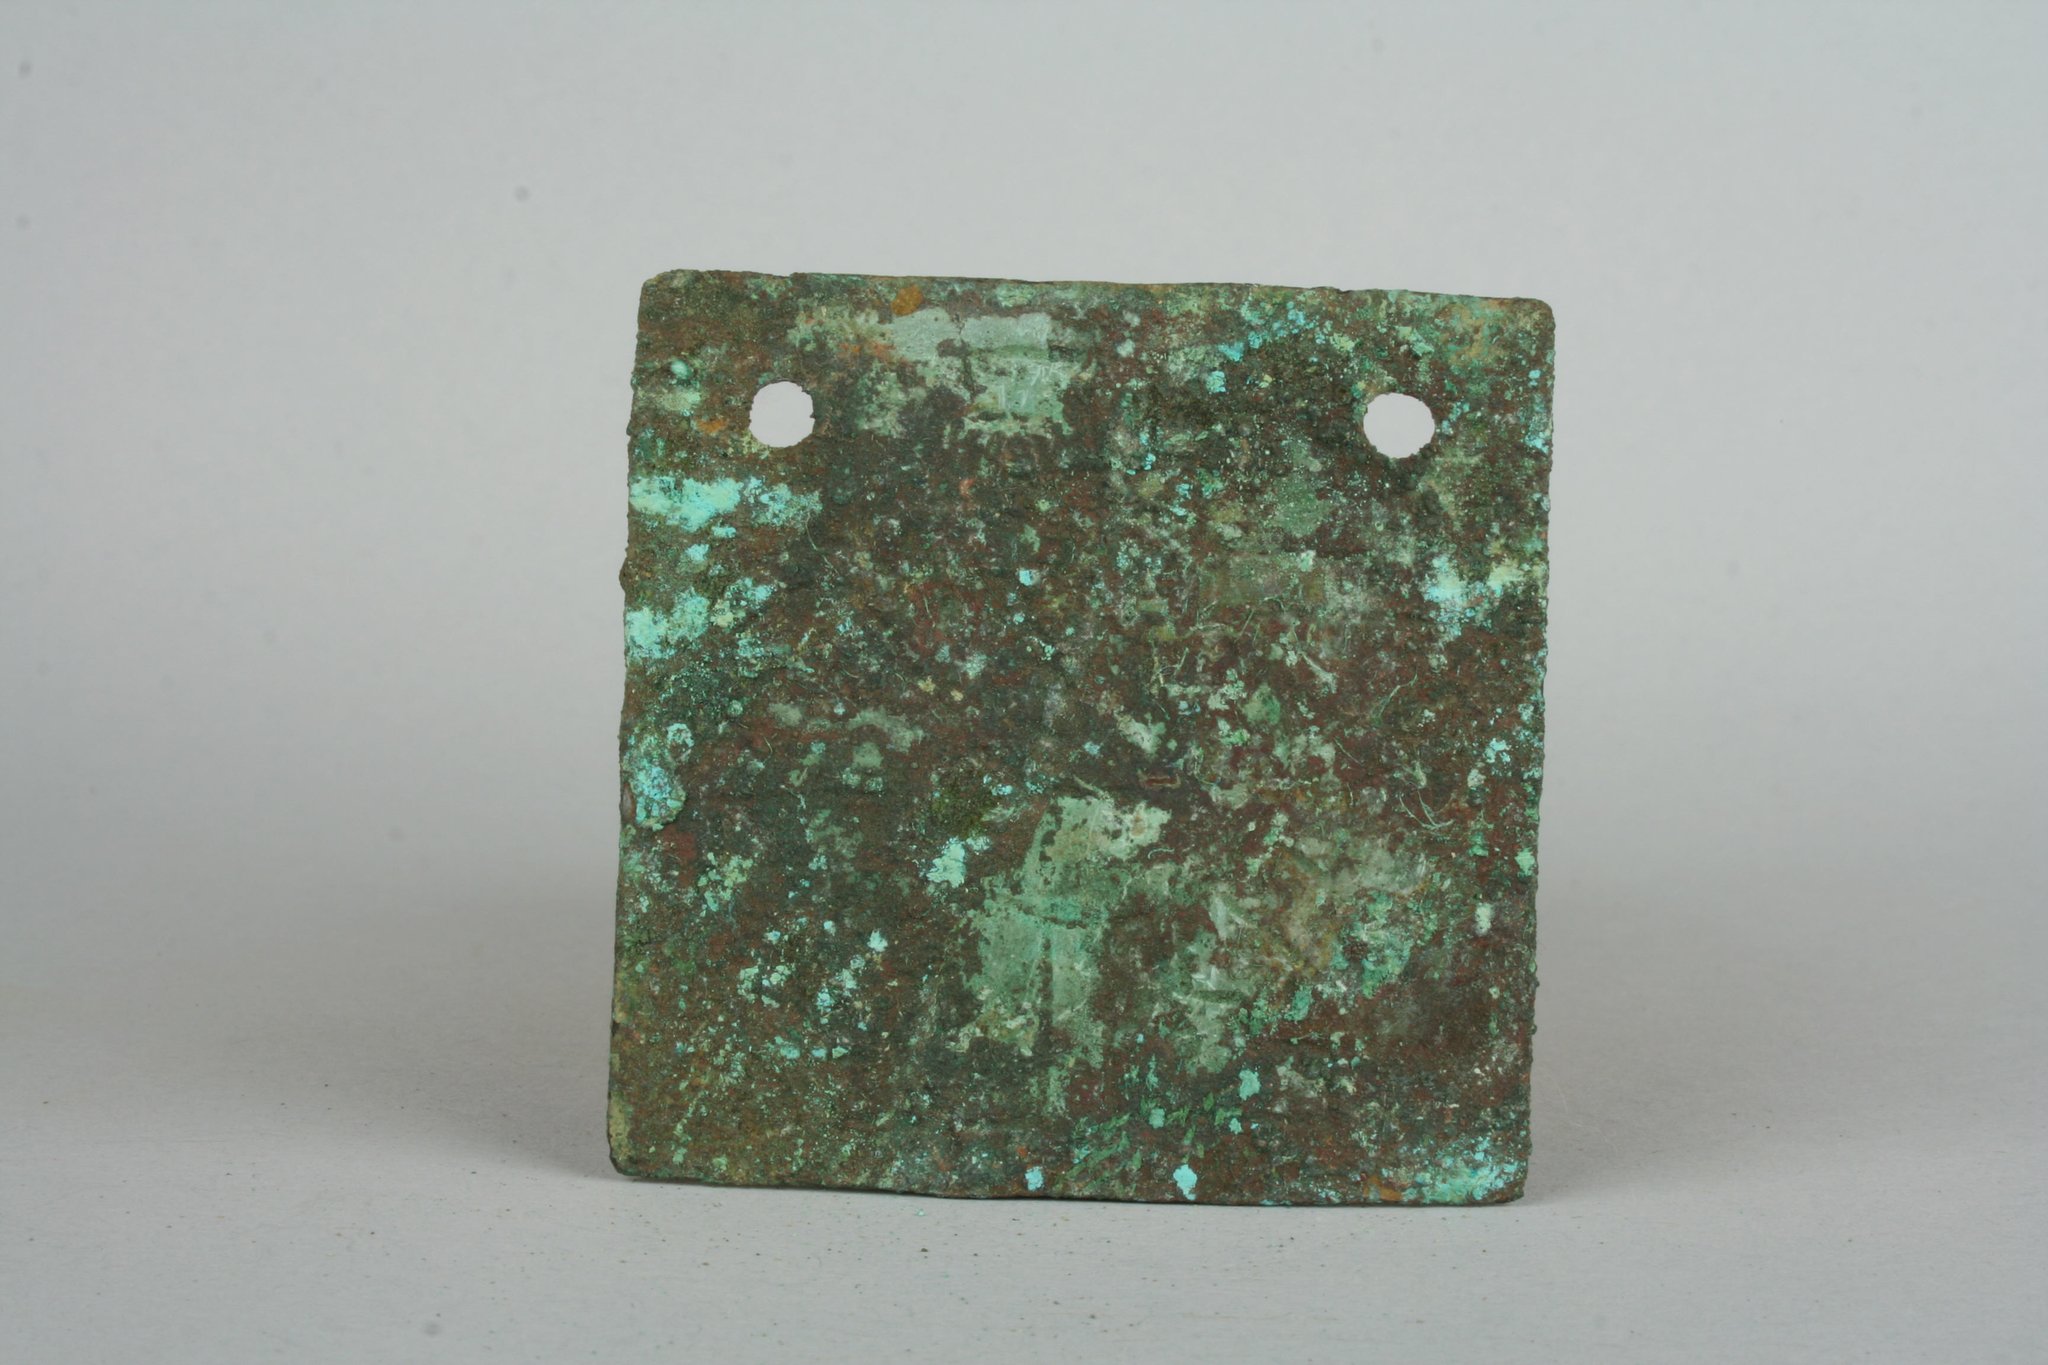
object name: ornament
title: Bird Plaque Ornament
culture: vicús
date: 300 BCE-200 CE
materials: copper, gilt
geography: peru